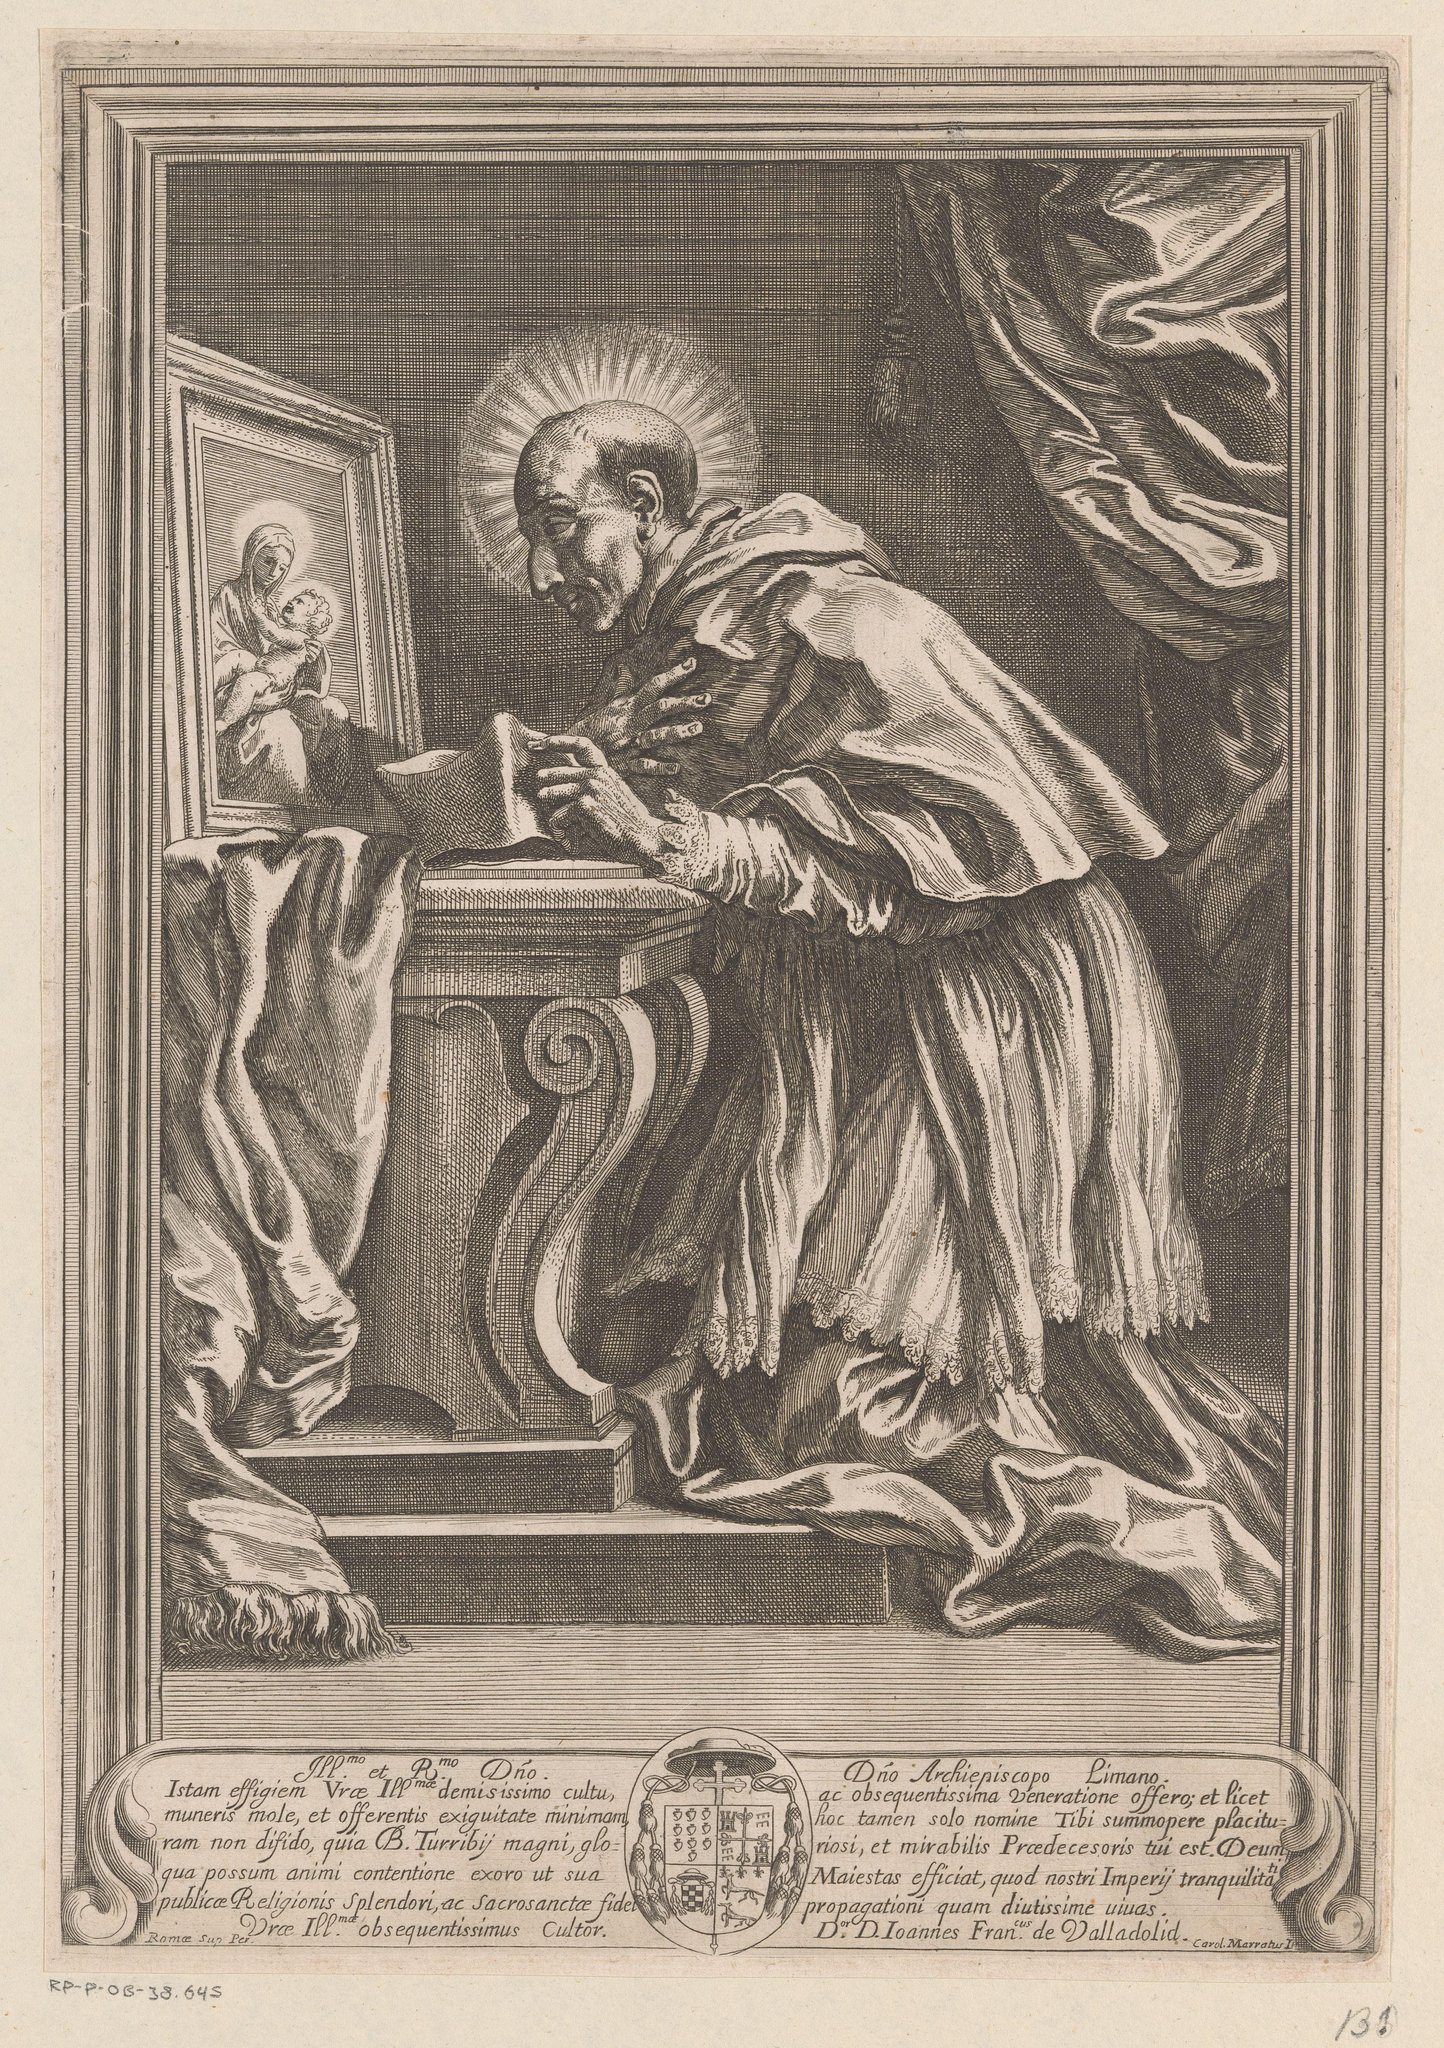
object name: print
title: Leven van de heilige Turibius de Mogrovejo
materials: paper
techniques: etching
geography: italy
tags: priest, turibius de mogrovejo, archbishop, bishop, etc. (roman catholic)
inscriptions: collector's mark: Lugt 240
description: De heilige Turibius de Mogrovejo, aartsbisschop van Lima, knielend voor een altaar met een beeltenis van Maria met Kind. Cartouche met opdracht in de ondermarge.